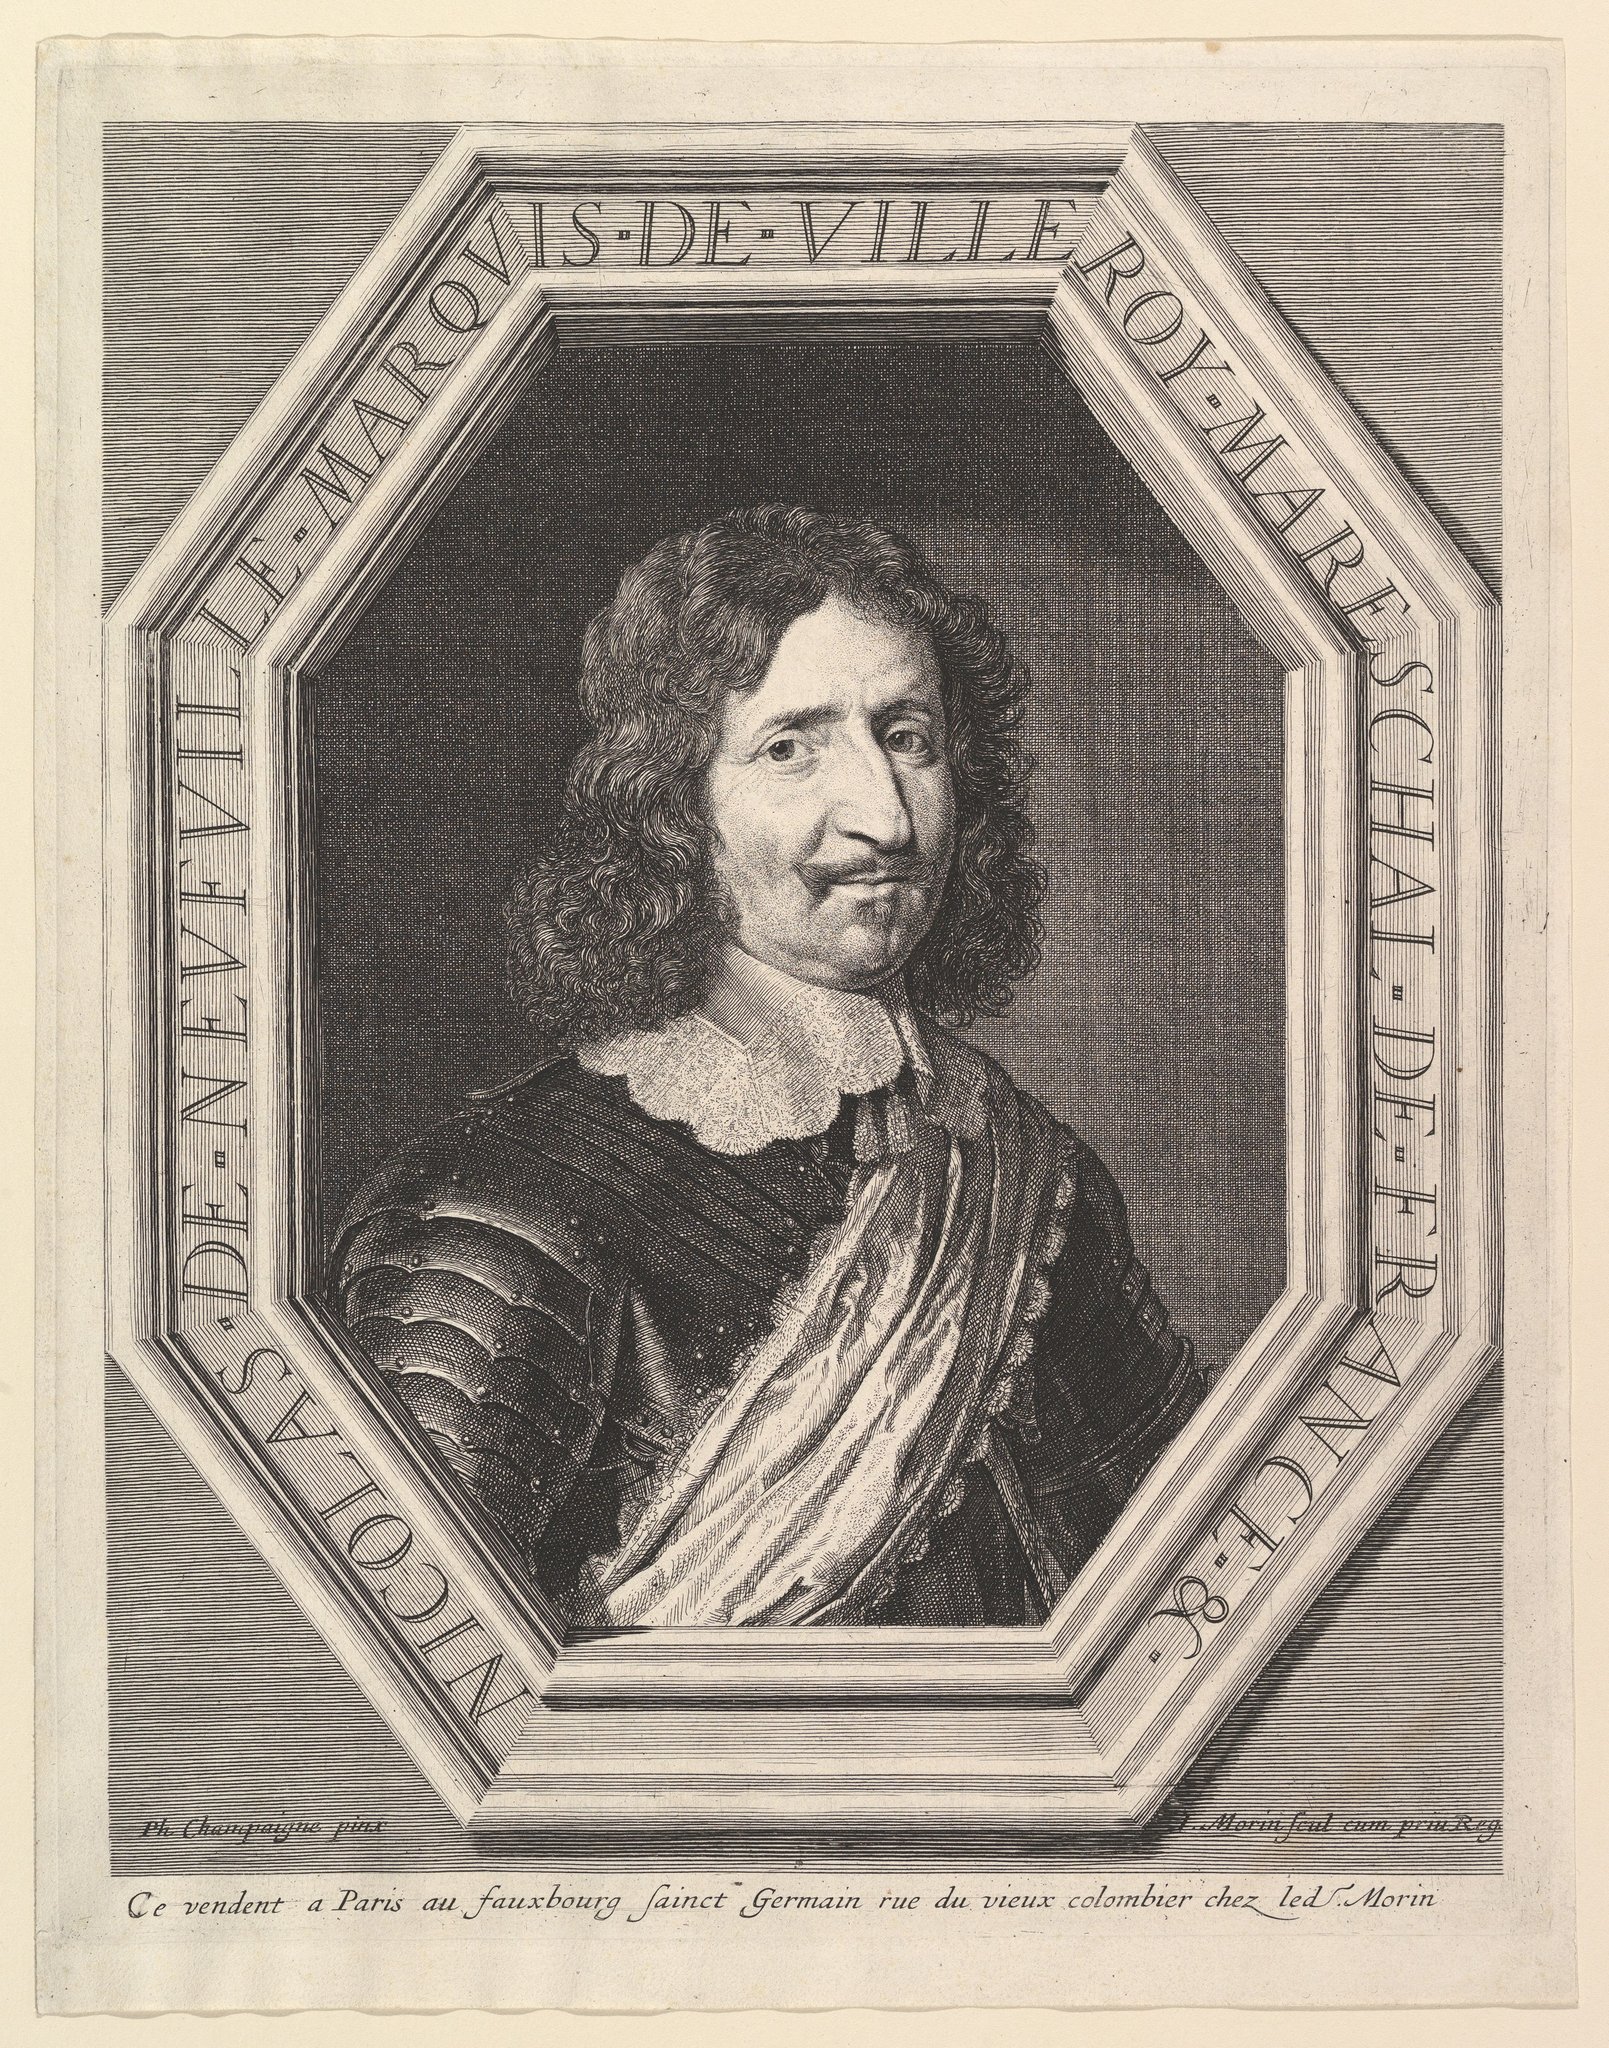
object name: print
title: Nicolas de Neuville, marquis de Villeroy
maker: jean morin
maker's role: artist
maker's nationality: french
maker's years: 1605-1650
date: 1605-1650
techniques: etching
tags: men,portraits